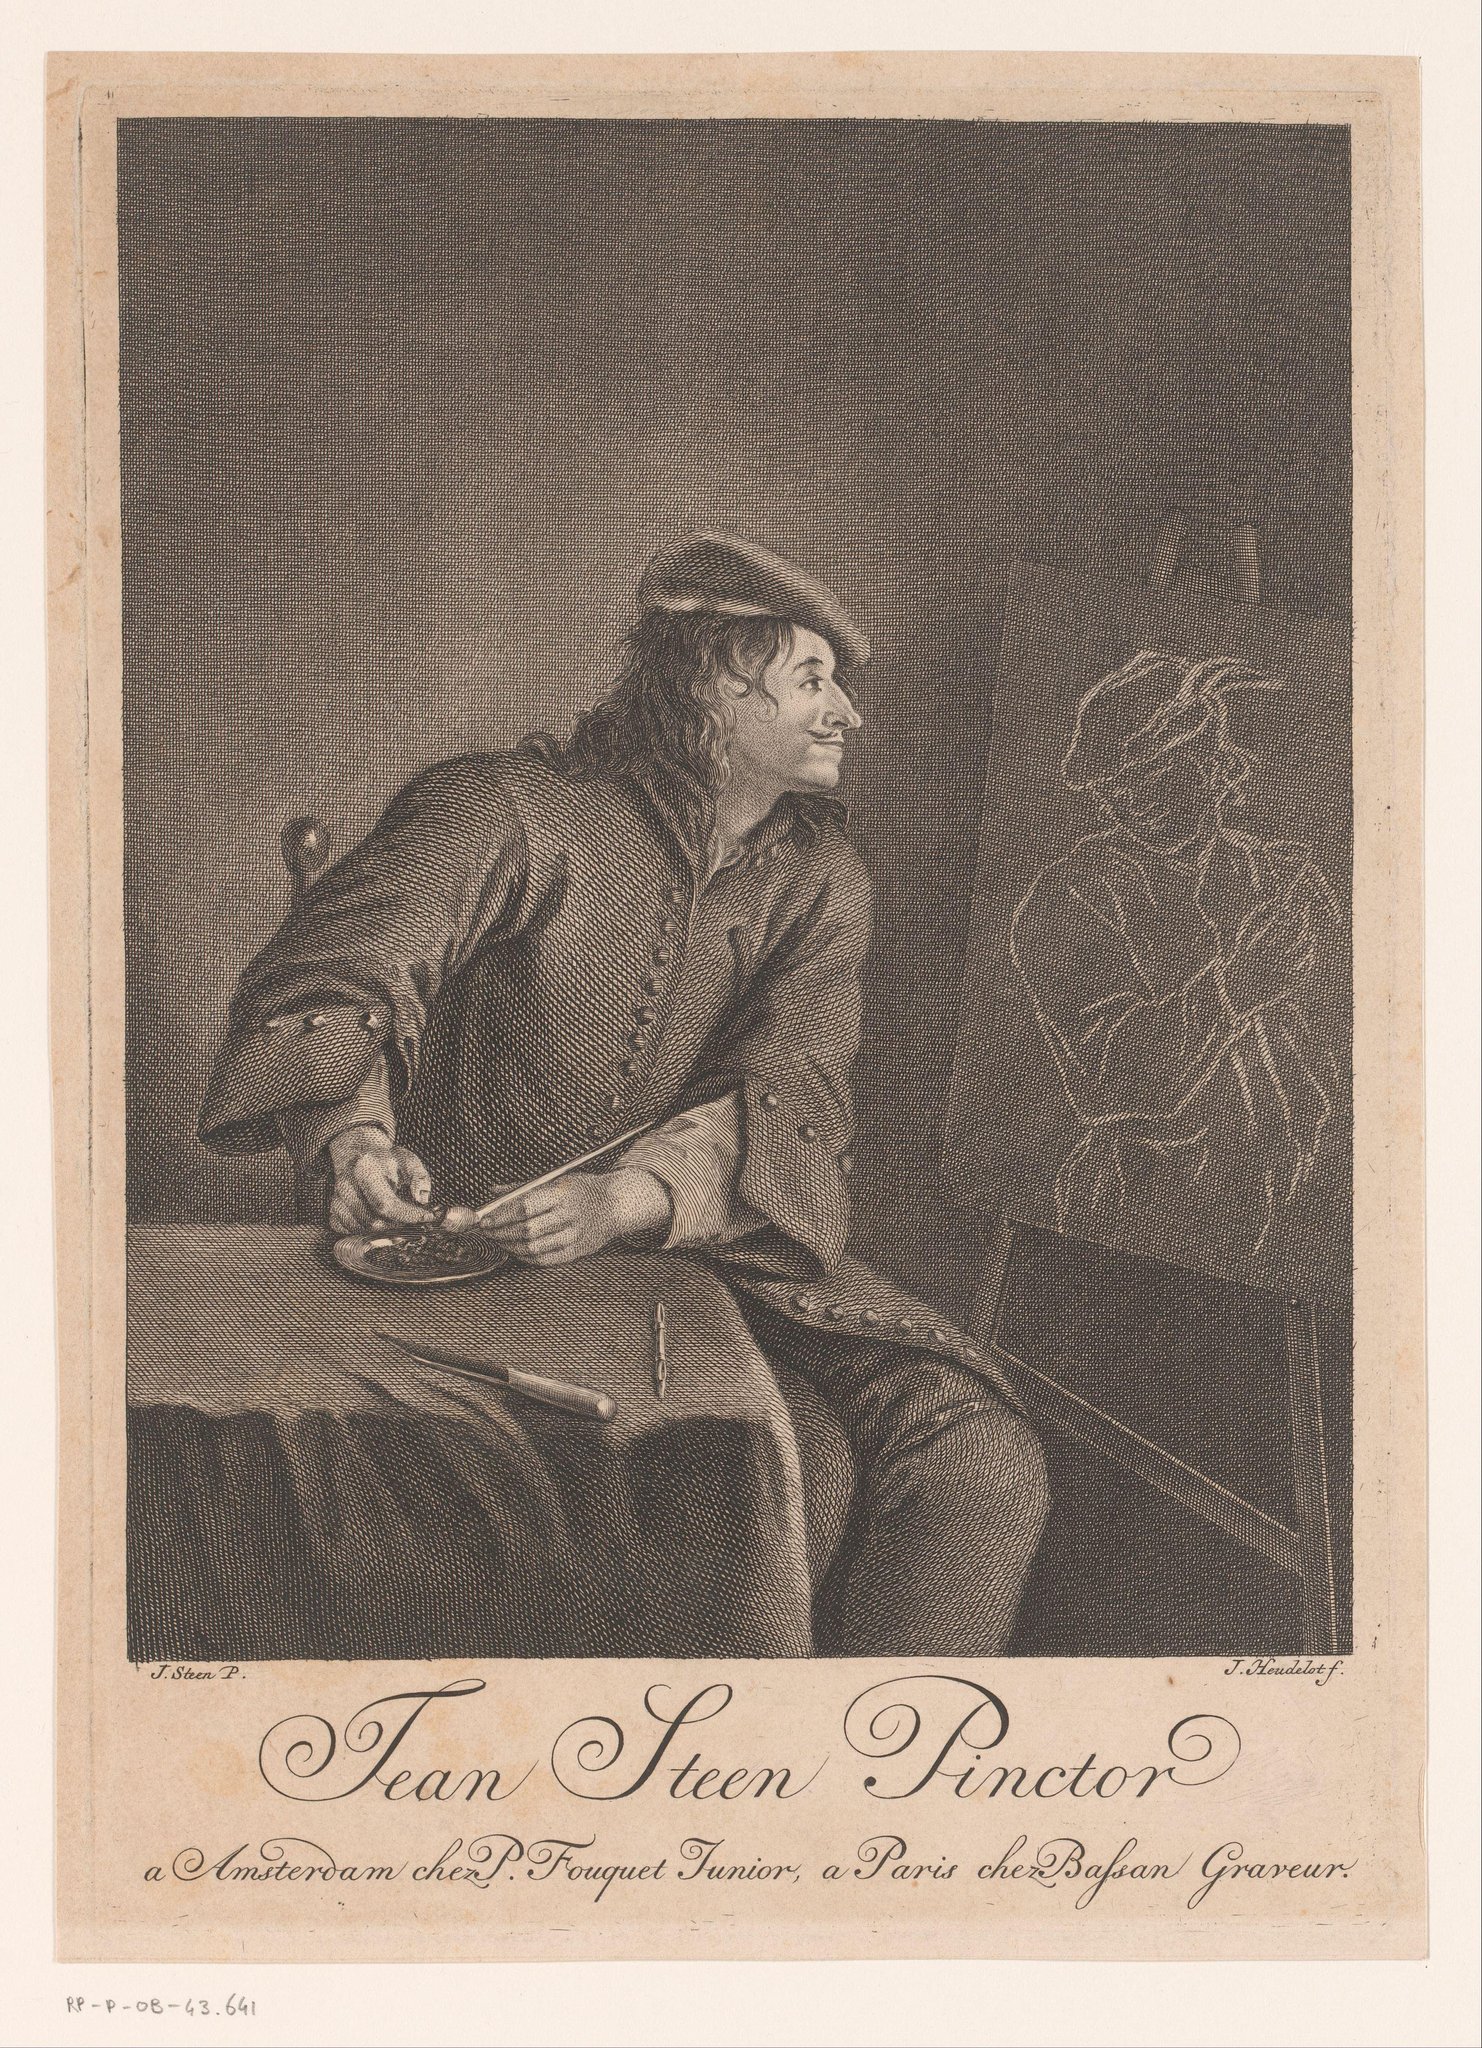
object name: print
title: Jean Steen Pinctor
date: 1750-1768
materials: paper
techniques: engraving, etching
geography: amsterdam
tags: leiden, painter, print maker, jan havicksz. steen, historical persons, portrait, self-portrait of artist, easel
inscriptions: collector's mark: Lugt 2228